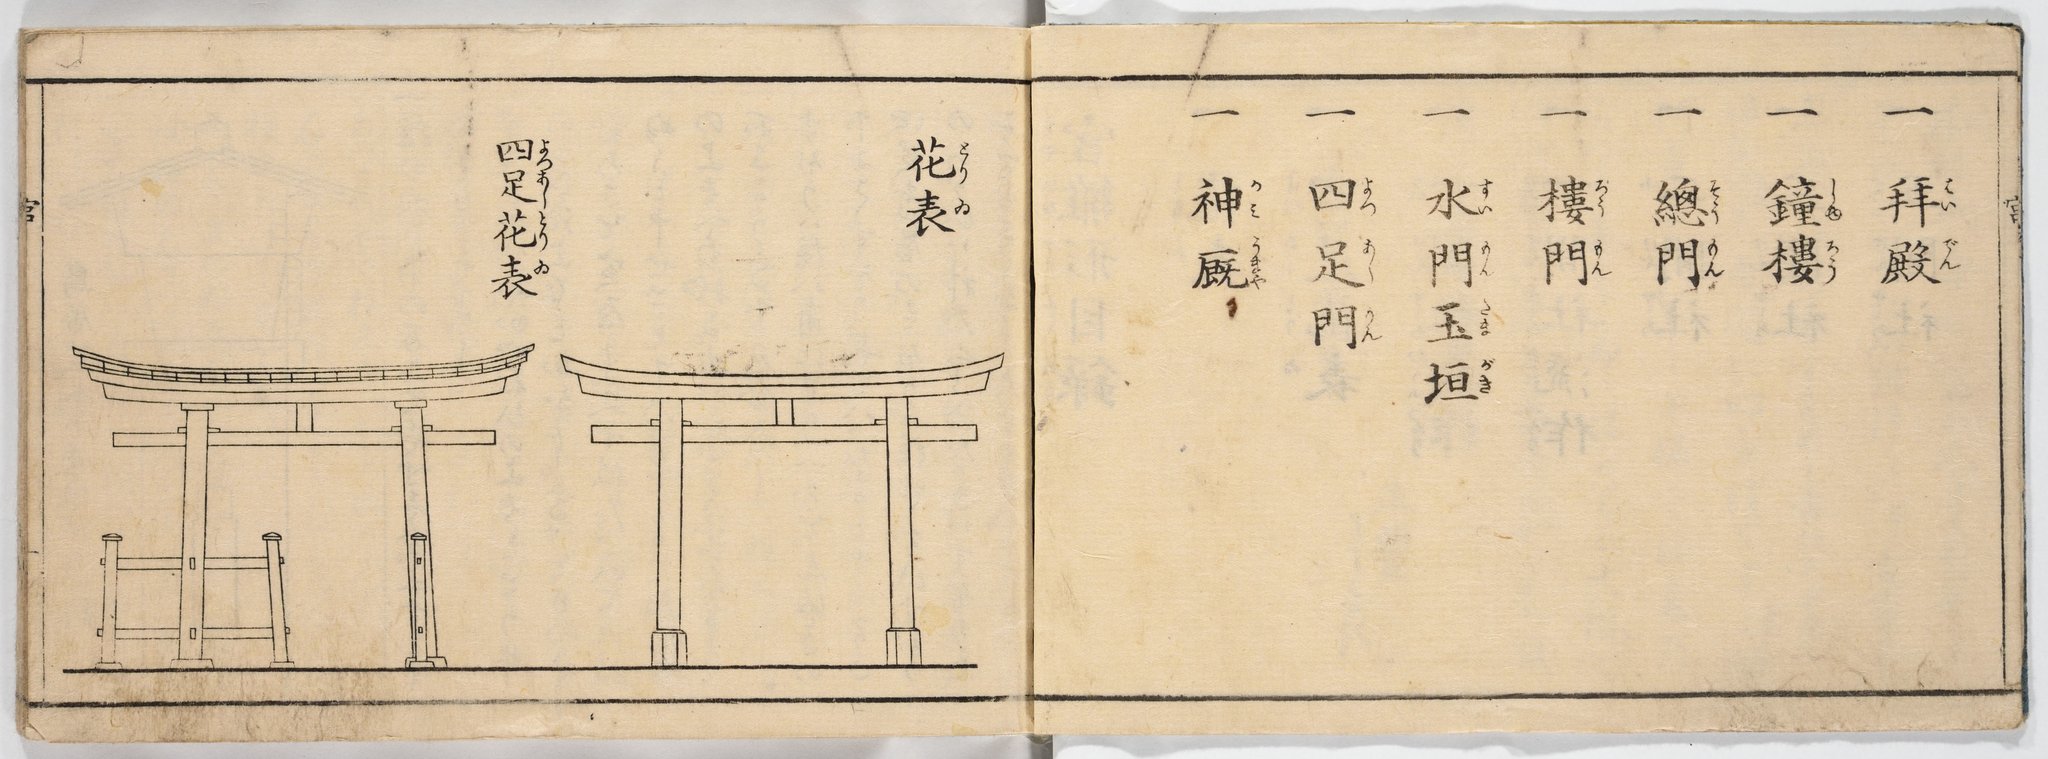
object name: illustrated book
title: New Illustrated Manual of Shrine Architecture (Shinpan/Miya hinagata)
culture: japanese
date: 1866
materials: ink, paper